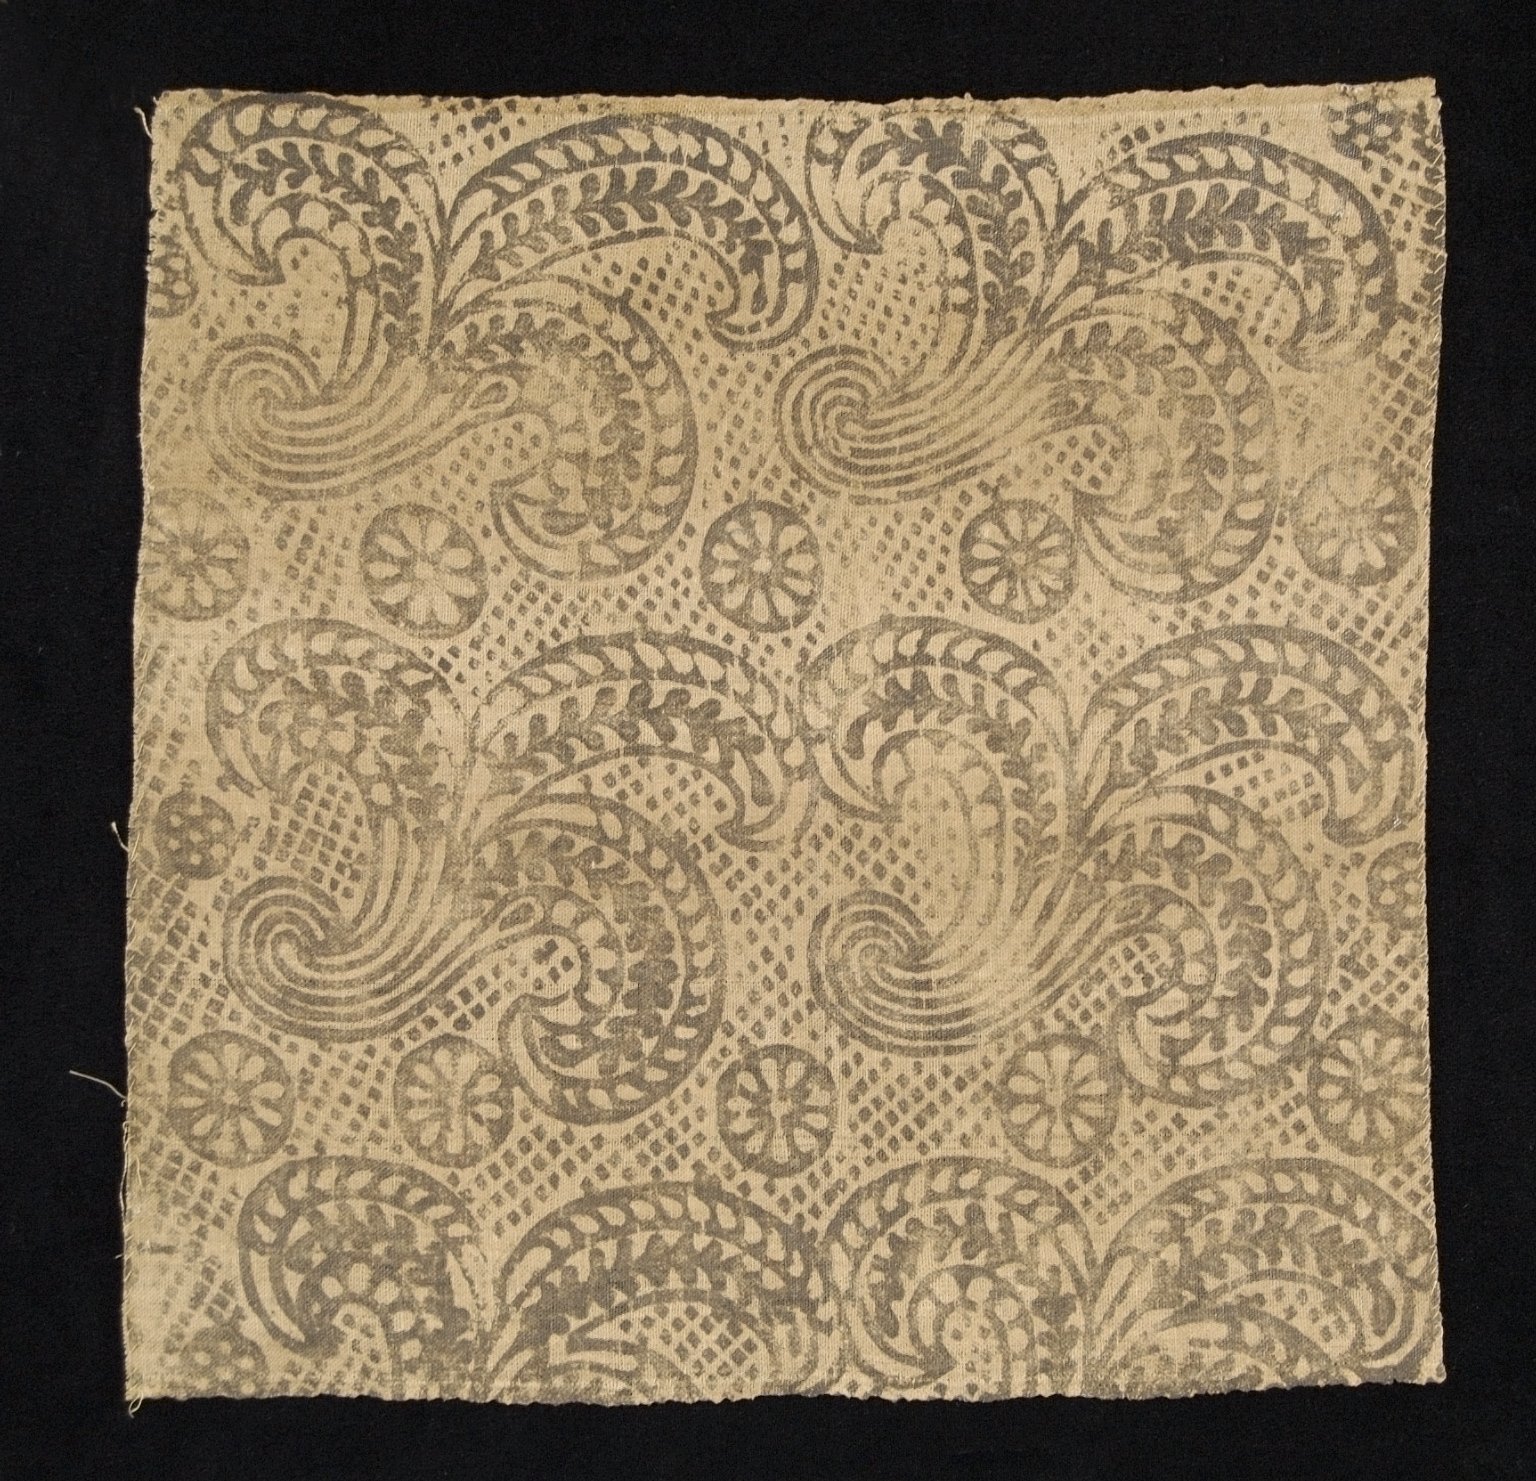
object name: fragment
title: Textile fragment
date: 1700-1899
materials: linen